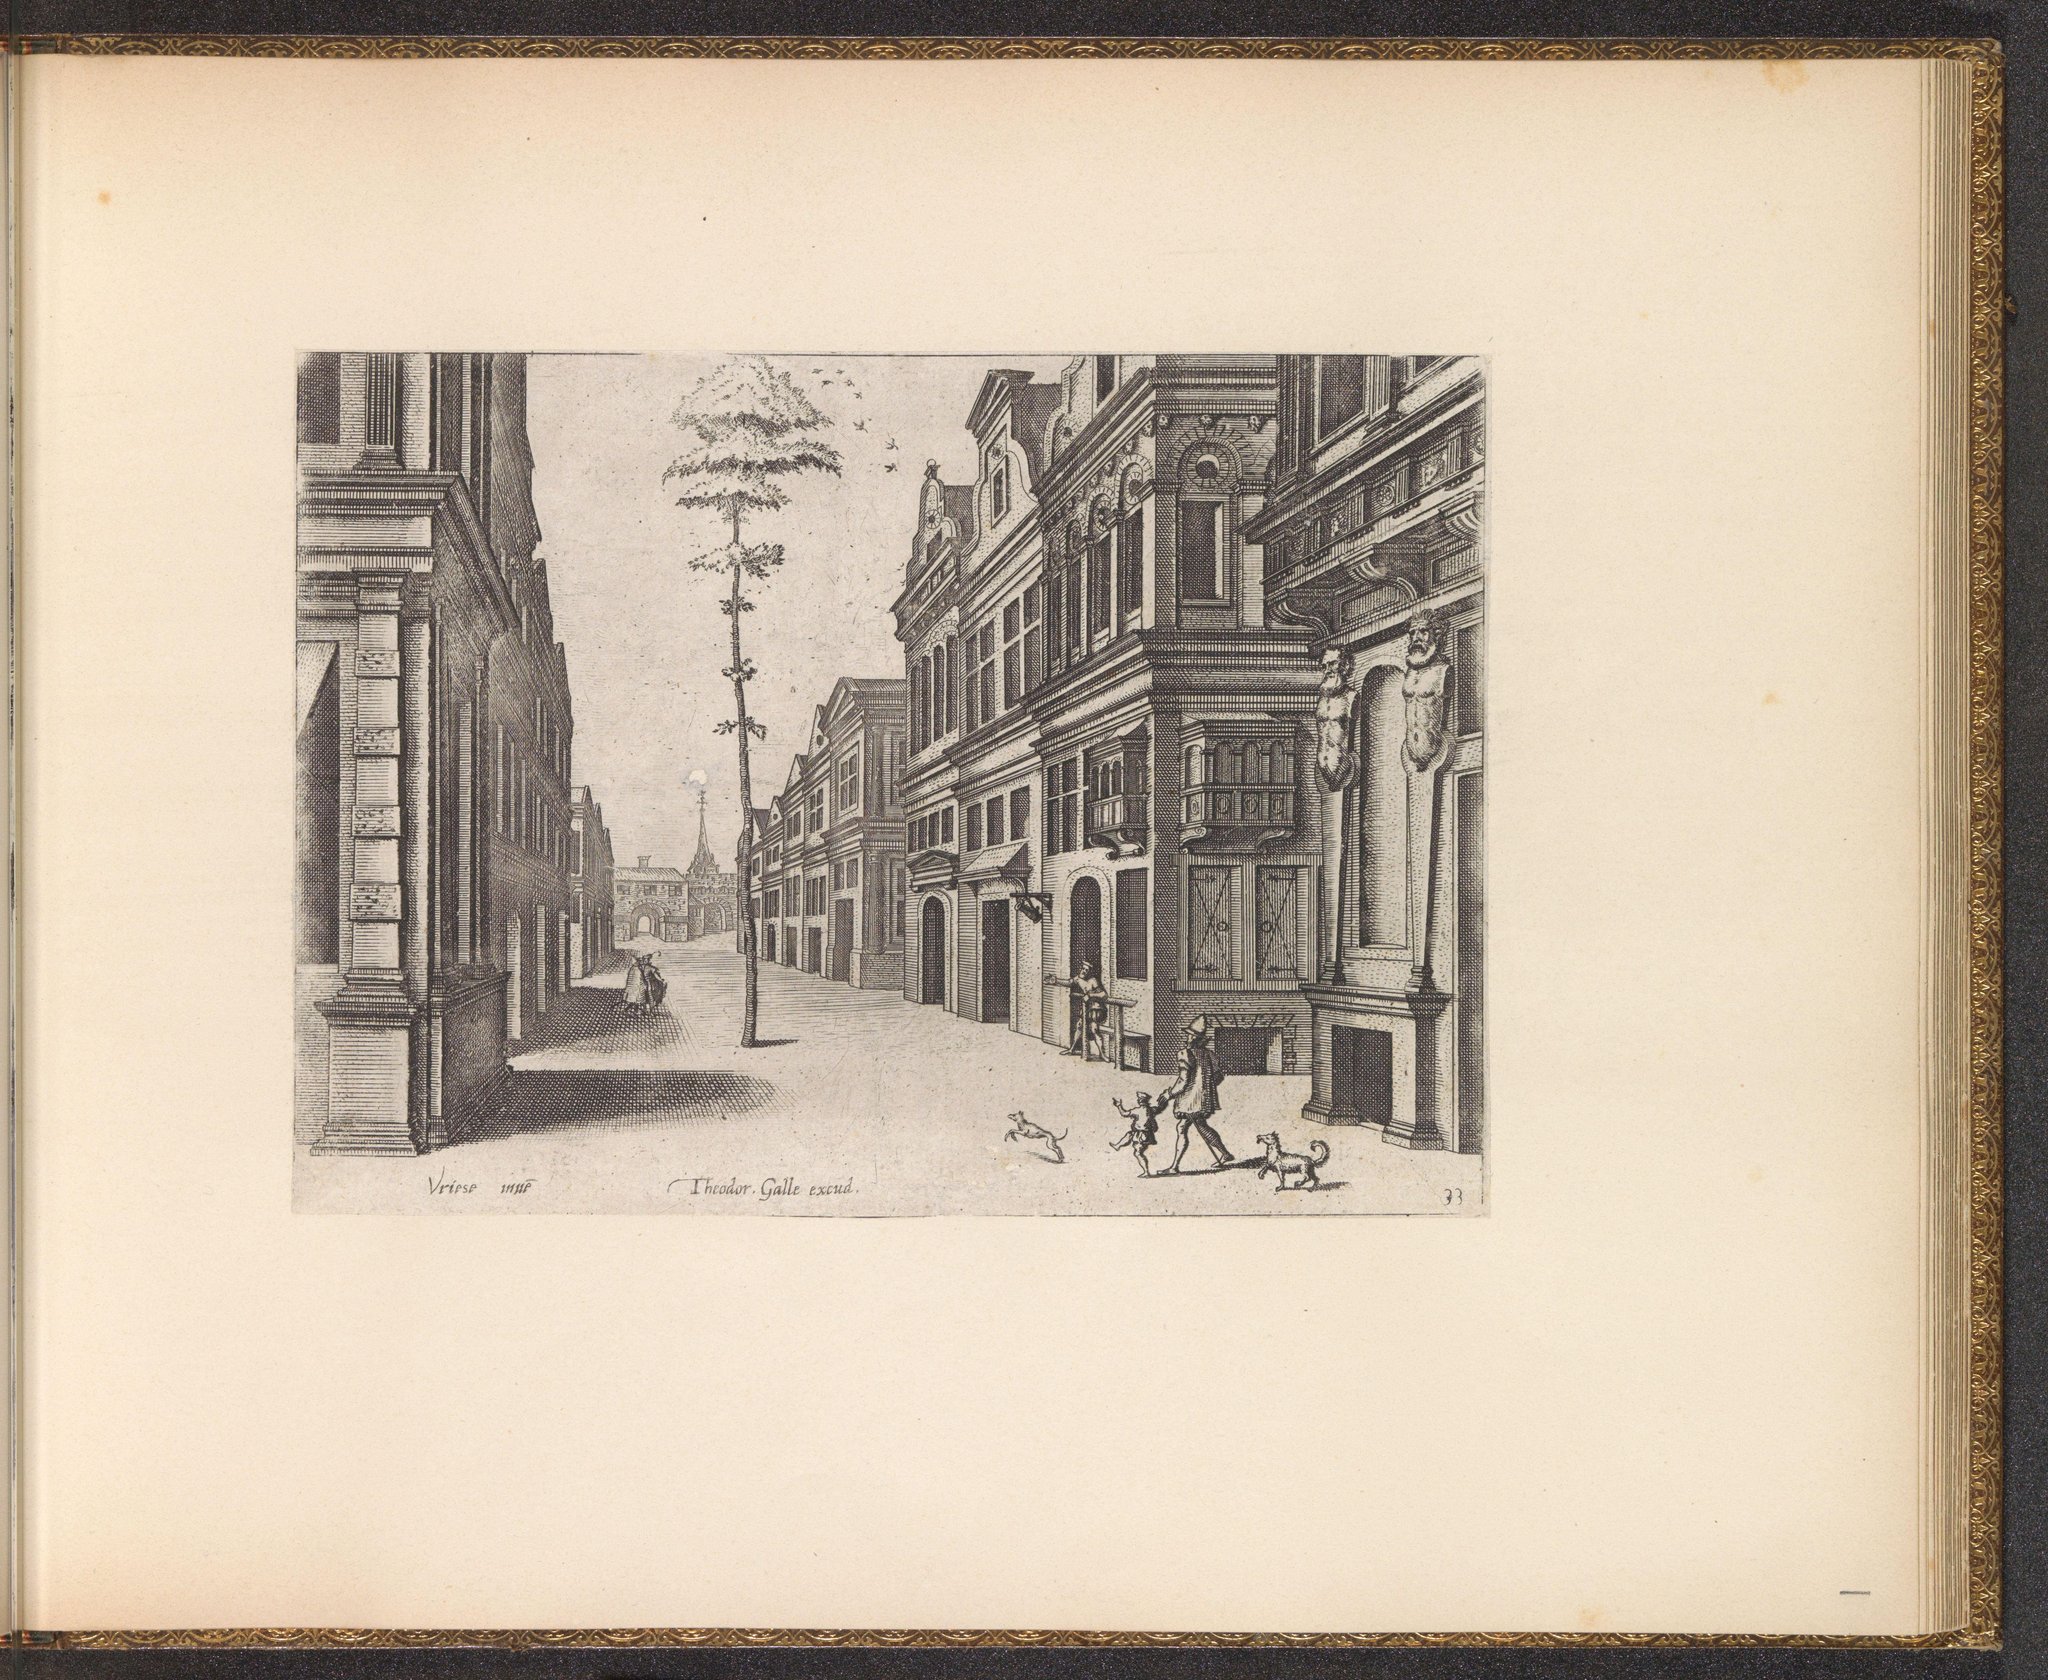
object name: ornament print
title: Straat met in het midden een boom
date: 1601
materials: paper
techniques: etching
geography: antwerp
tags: city-view in general; 'veduta', street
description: Straat met links en rechts gebouwen en in het midden een boom. Rechts vooraan een man met een kind en twee honden. De prent maakt deel uit van een album.